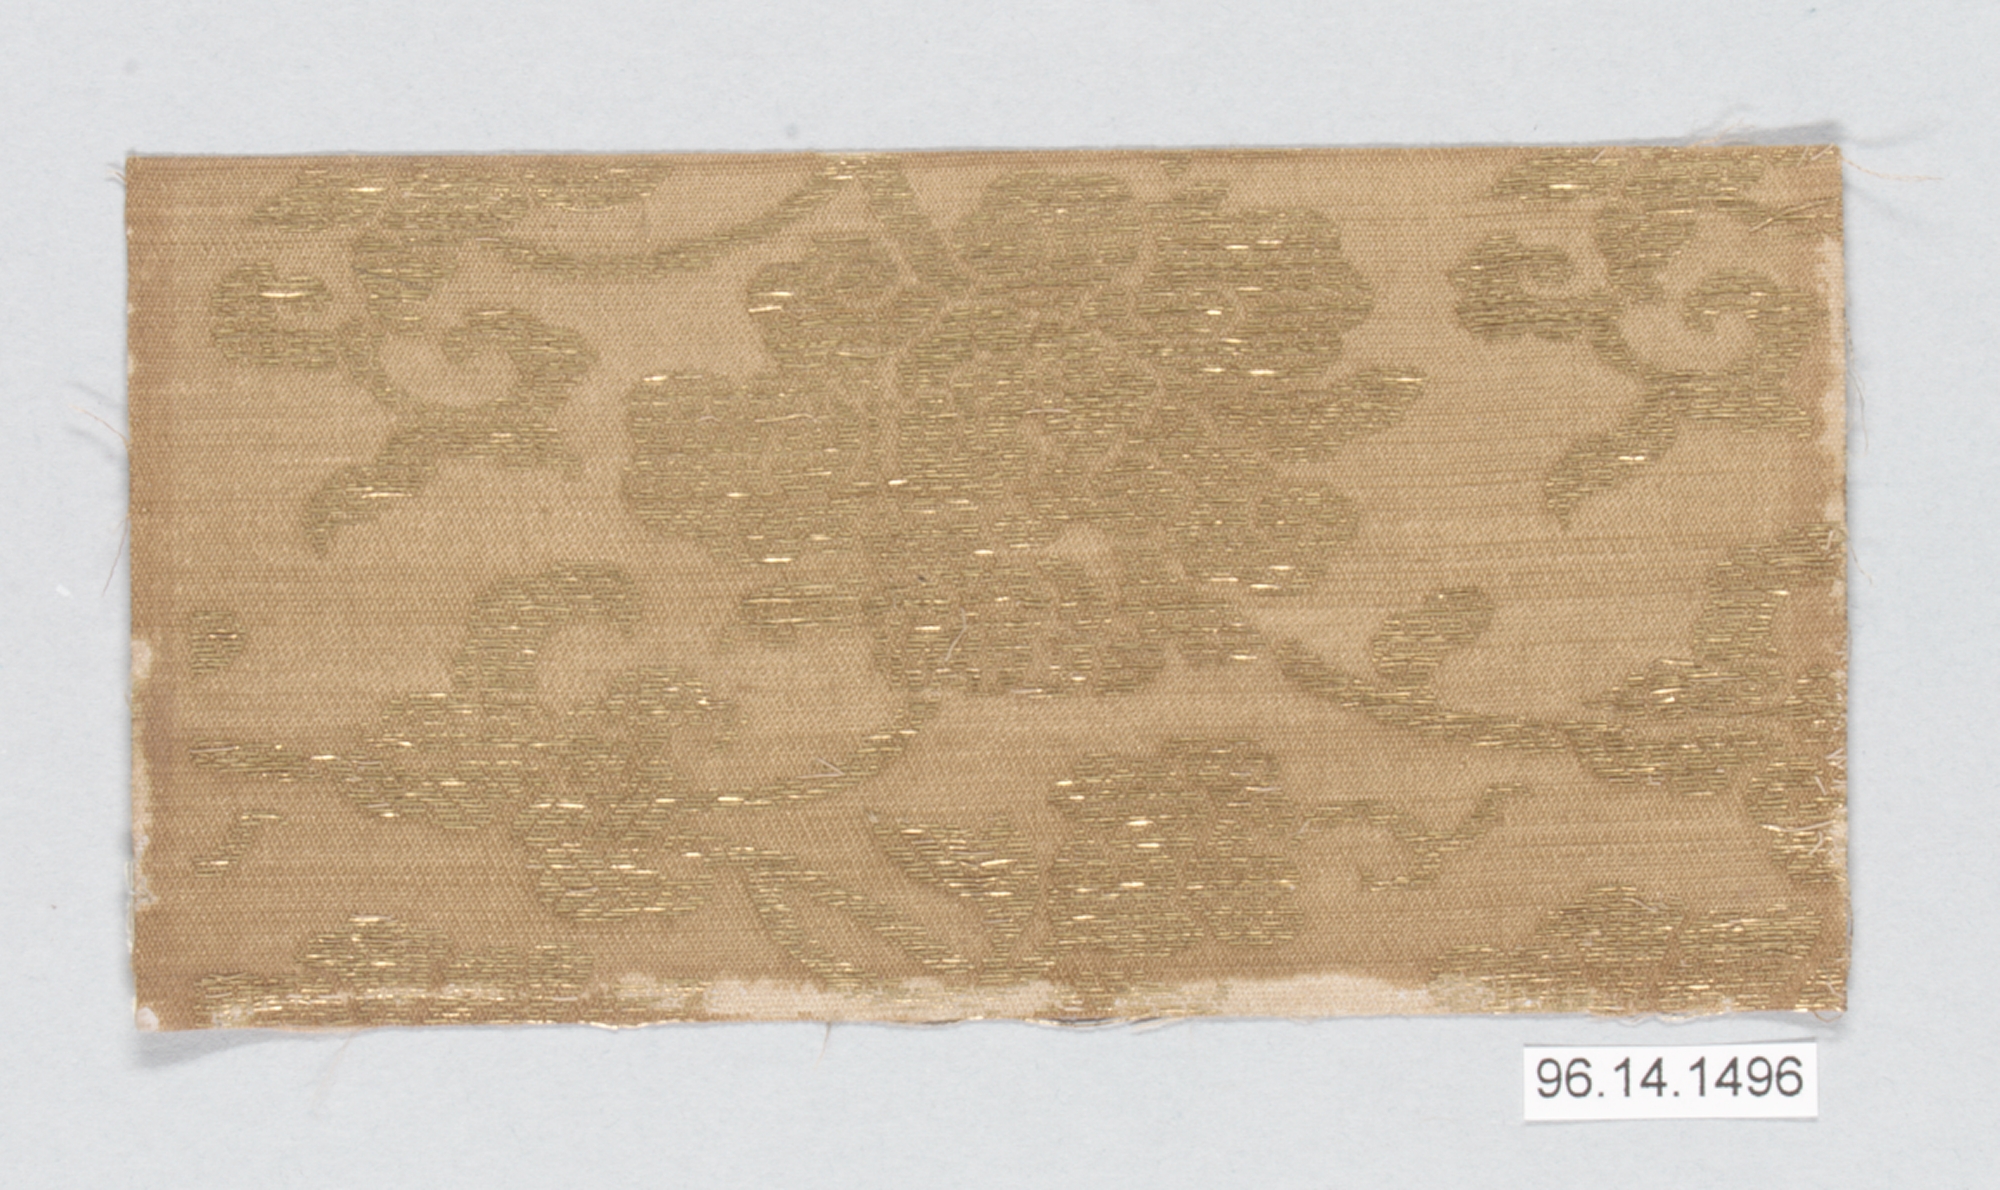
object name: piece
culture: japanese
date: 1701-1900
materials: silk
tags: flowers